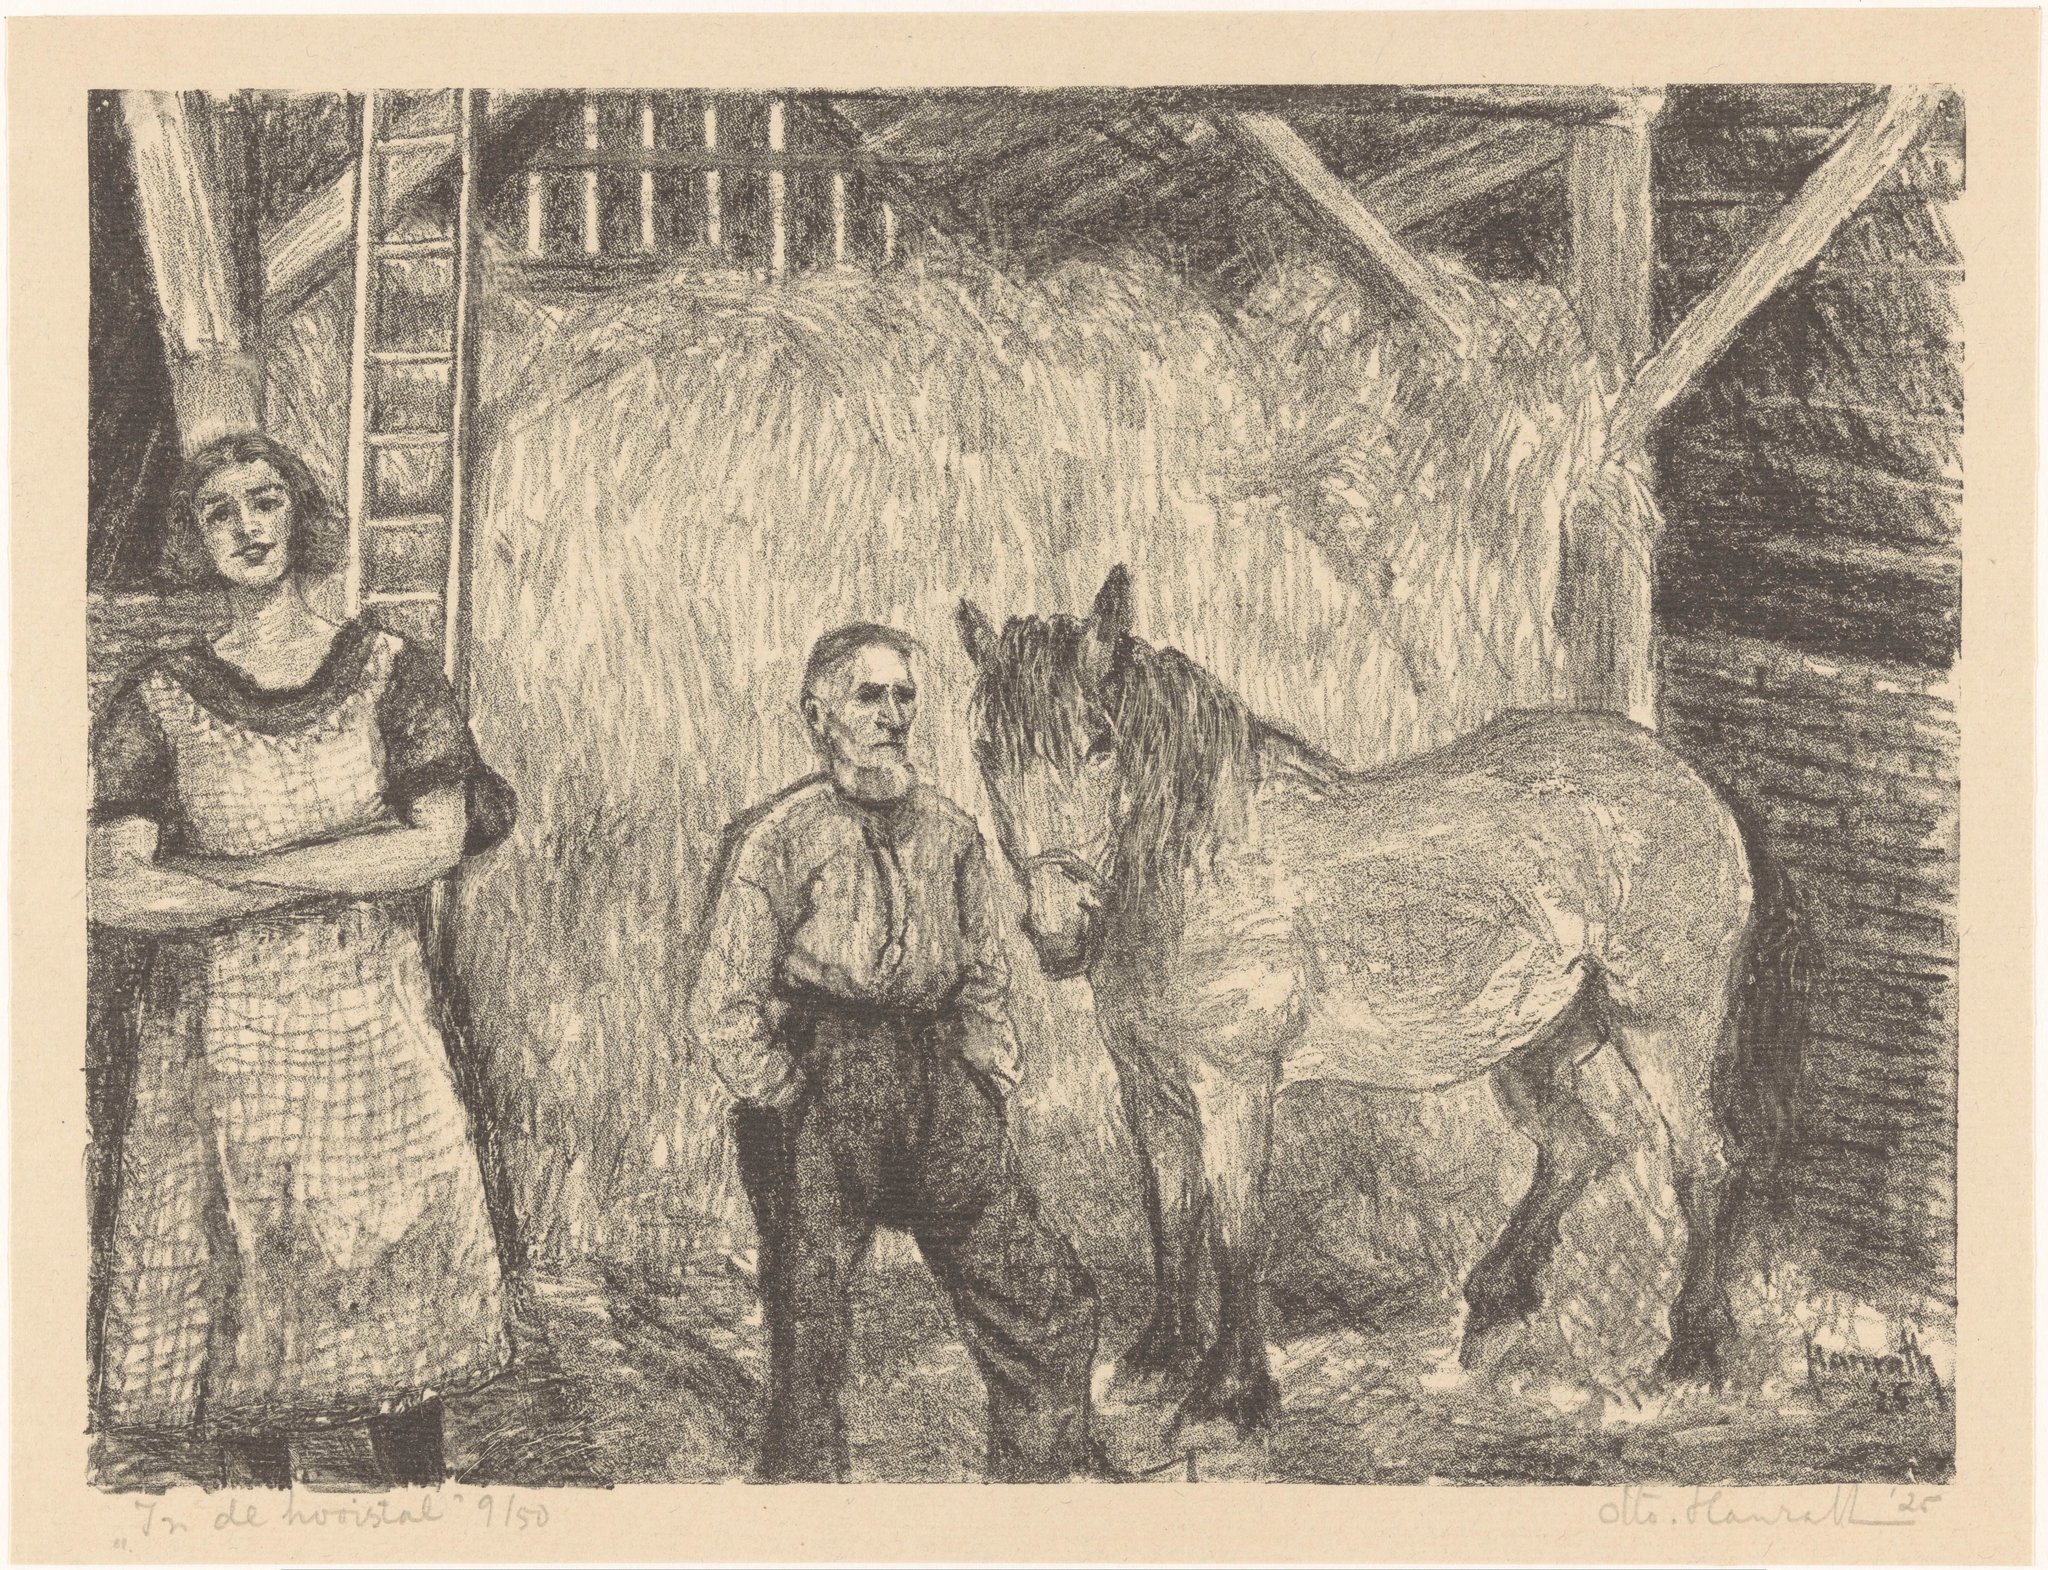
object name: print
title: In de hooistal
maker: otto hanrath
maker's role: print maker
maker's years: 1882-1944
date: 1925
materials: paper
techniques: lithograph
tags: farmers, barn - aa - civic architecture: inside, horse, hay-stack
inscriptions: collector's mark: Lugt 2228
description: Een boer, een boerin en een paard in en stal waarin hooi ligt opgeslagen.